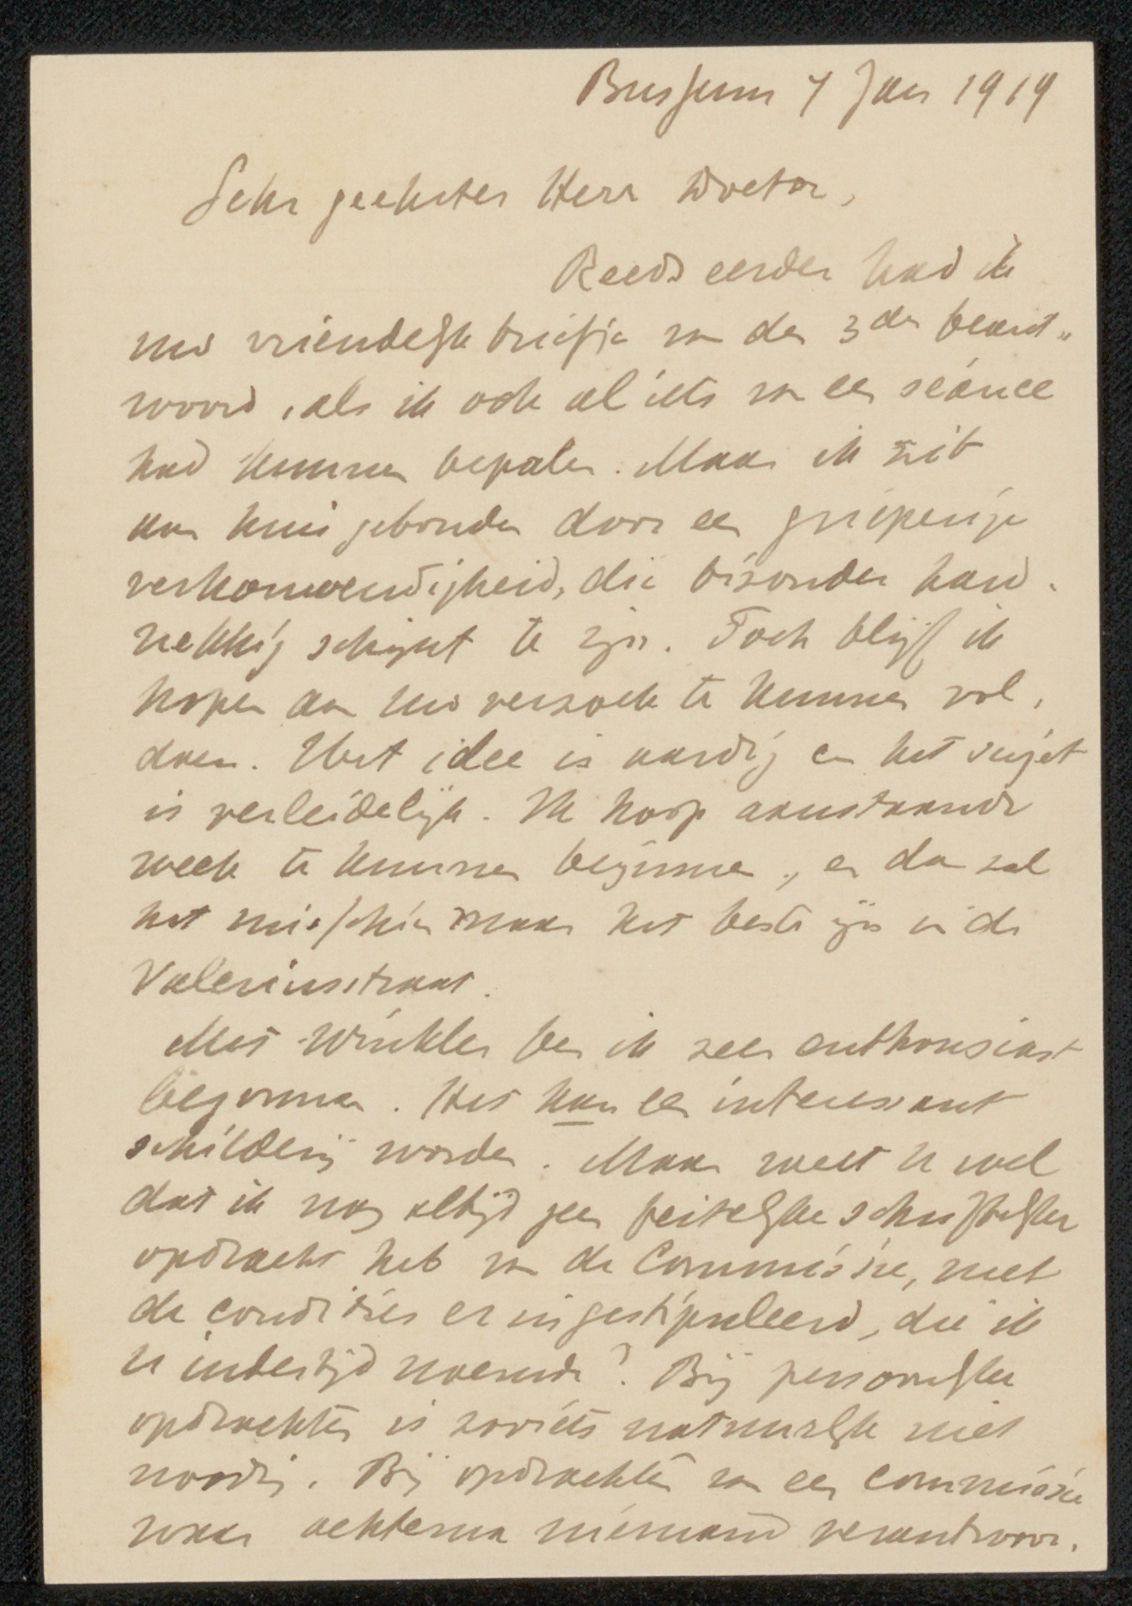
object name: letter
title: Brief aan C.C. Delprat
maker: jan veth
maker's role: designer, draughtsman, painter, print maker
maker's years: 1864-1925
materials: cardboard, ink, pencil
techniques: pen, writing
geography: bussum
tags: c.c. delprat, cornelis winkler, painting (including book-illumination, miniature-painting), diseases, historical persons (portraits and scenes from the life), money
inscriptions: collector's mark: ‘RPK’